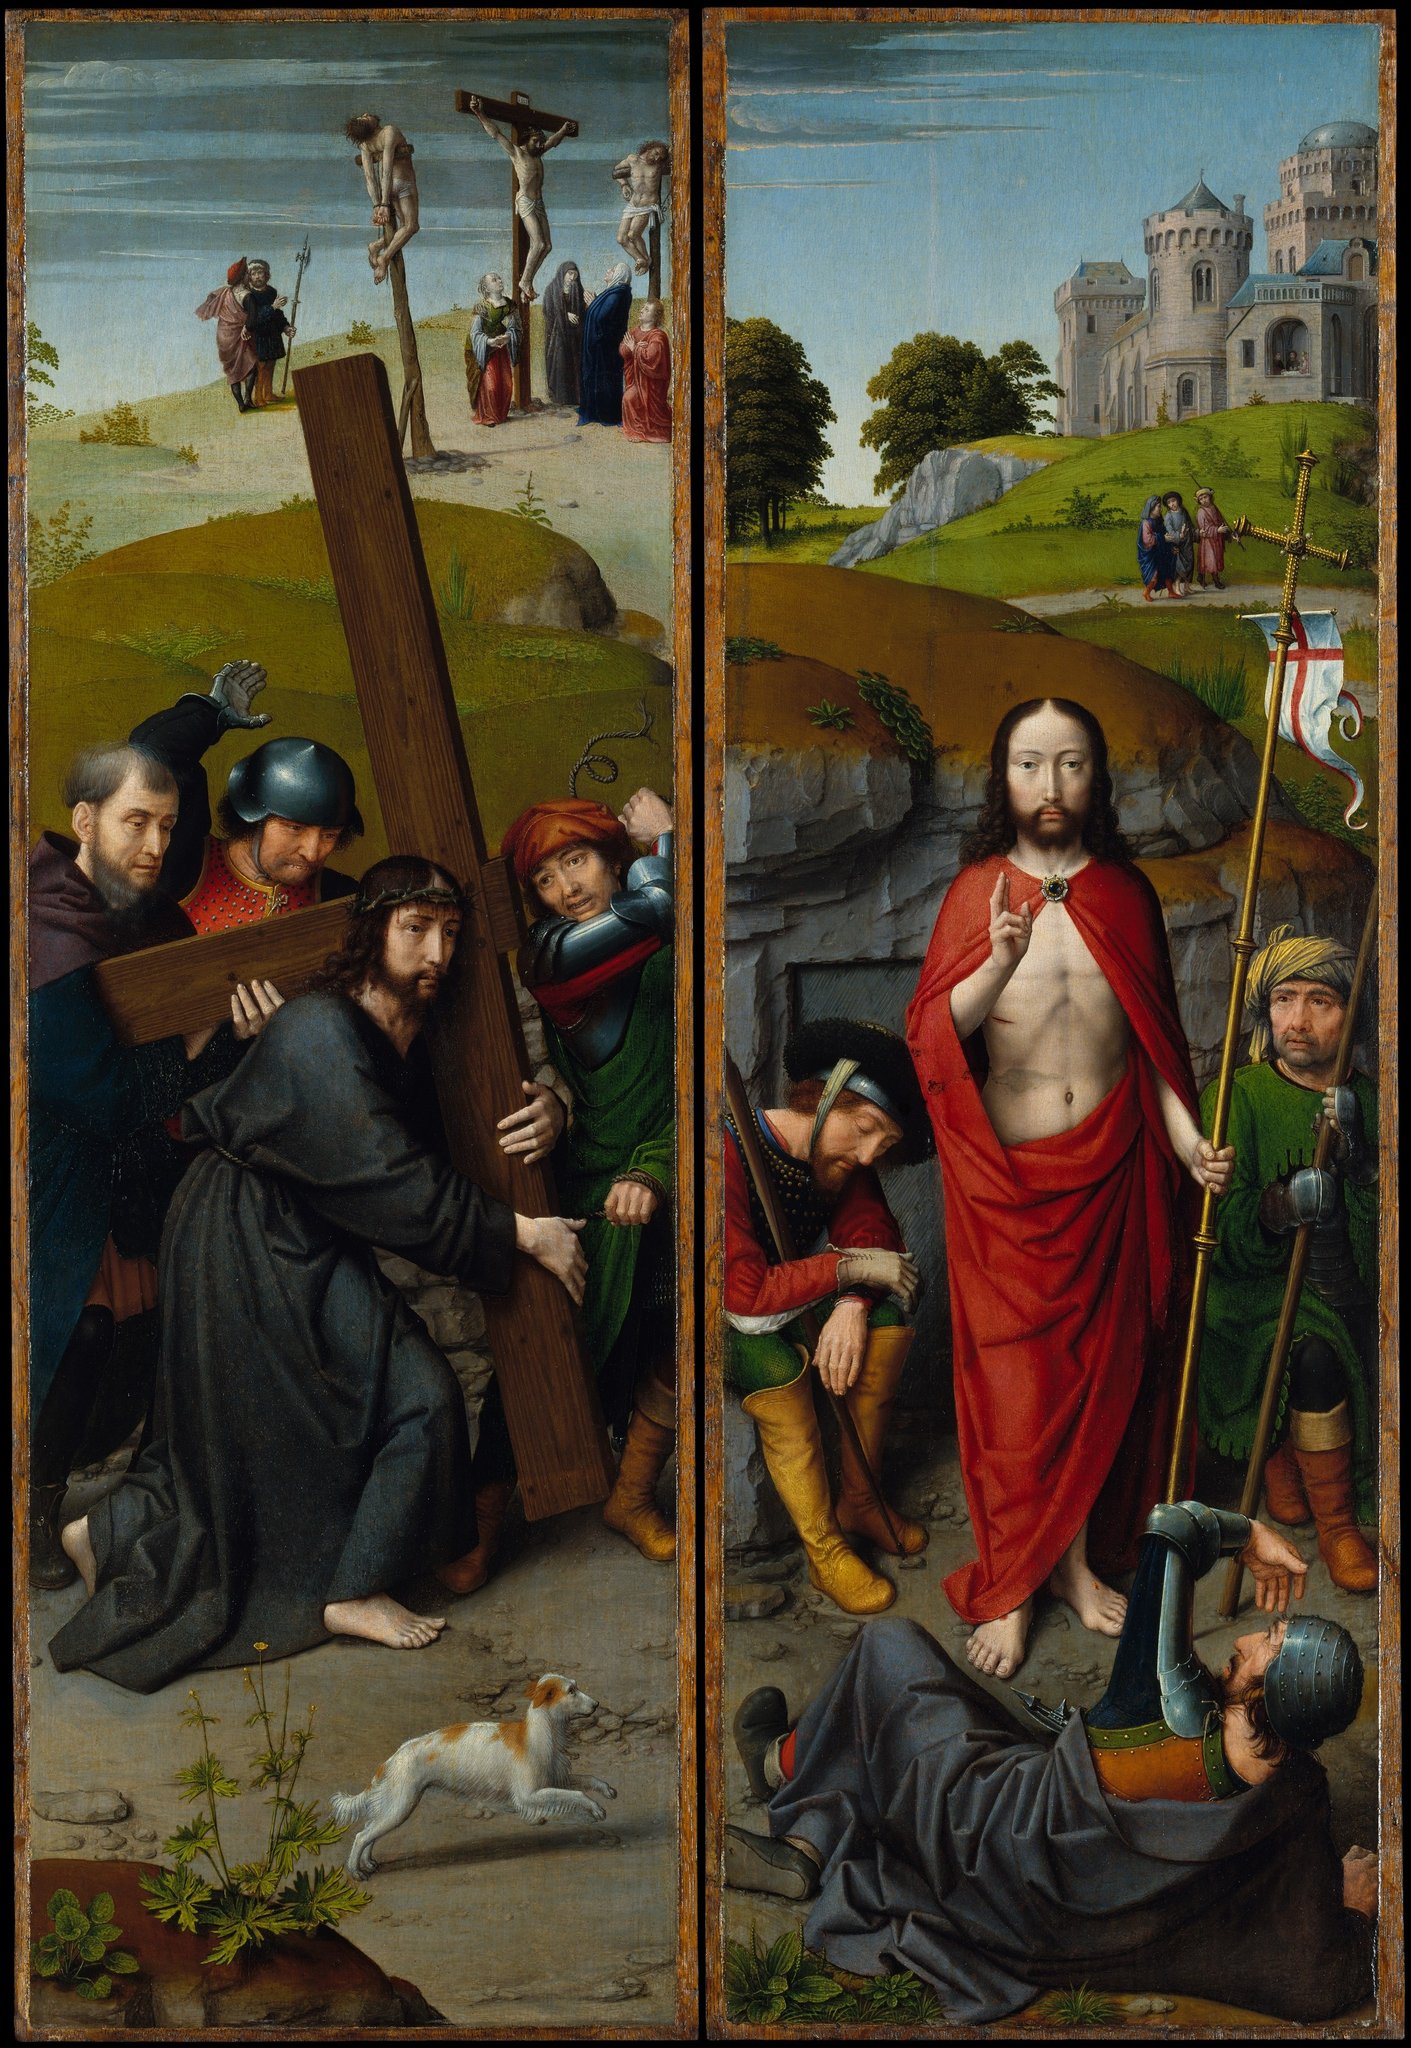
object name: triptych panel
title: Christ Carrying the Cross, with the Crucifixion; The Resurrection, with the Pilgrims of Emmaus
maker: gerard david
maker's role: artist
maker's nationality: netherlandish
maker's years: 1455-1523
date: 1510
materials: wood, oil, panel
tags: men,dogs,christ,bearing the cross,crucifixion,resurrection